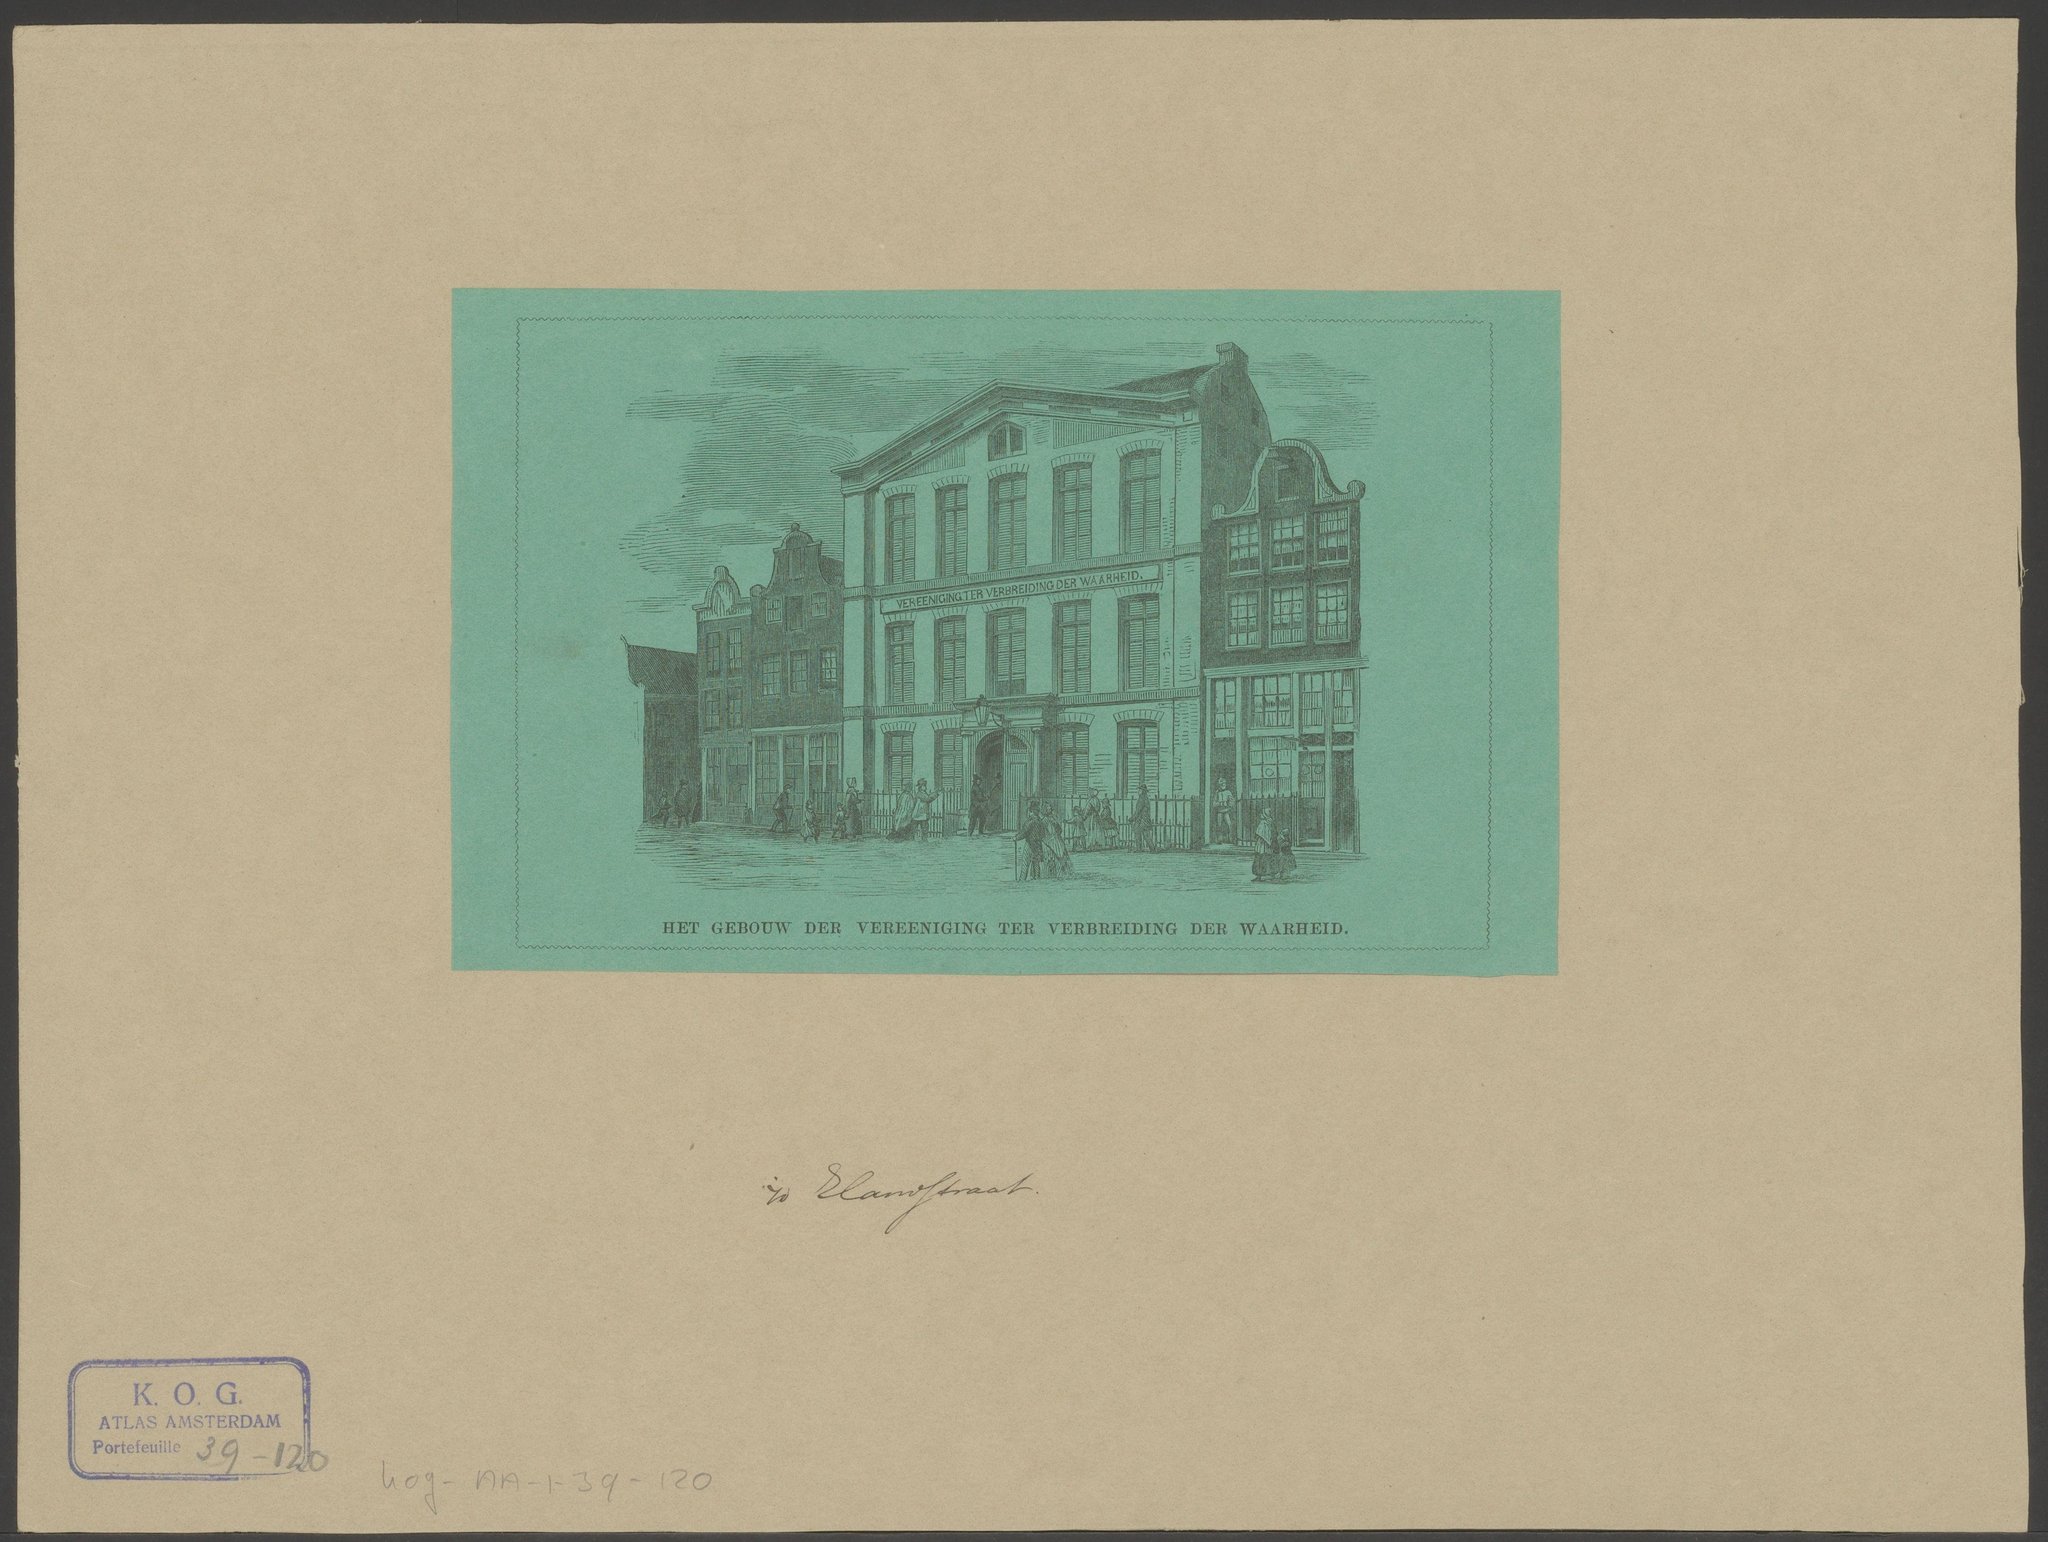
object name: print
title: Het gebouw der Vereeniging ter Verbreiding der Waarheid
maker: Anonymous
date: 1864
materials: paper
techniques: letterpress printing, engraving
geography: netherlands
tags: street (+ city(-scape) with figures, staffage)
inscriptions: collector's mark: Lugt 1641b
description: Onderwerpsrubriek binnen de Atlas Amsterdam: Armwezen en liefdadige instellingen: III. Verschillende gestichten en instellingen / Hofjes: Vereeniging ter Verbreiding van de Waarheid.